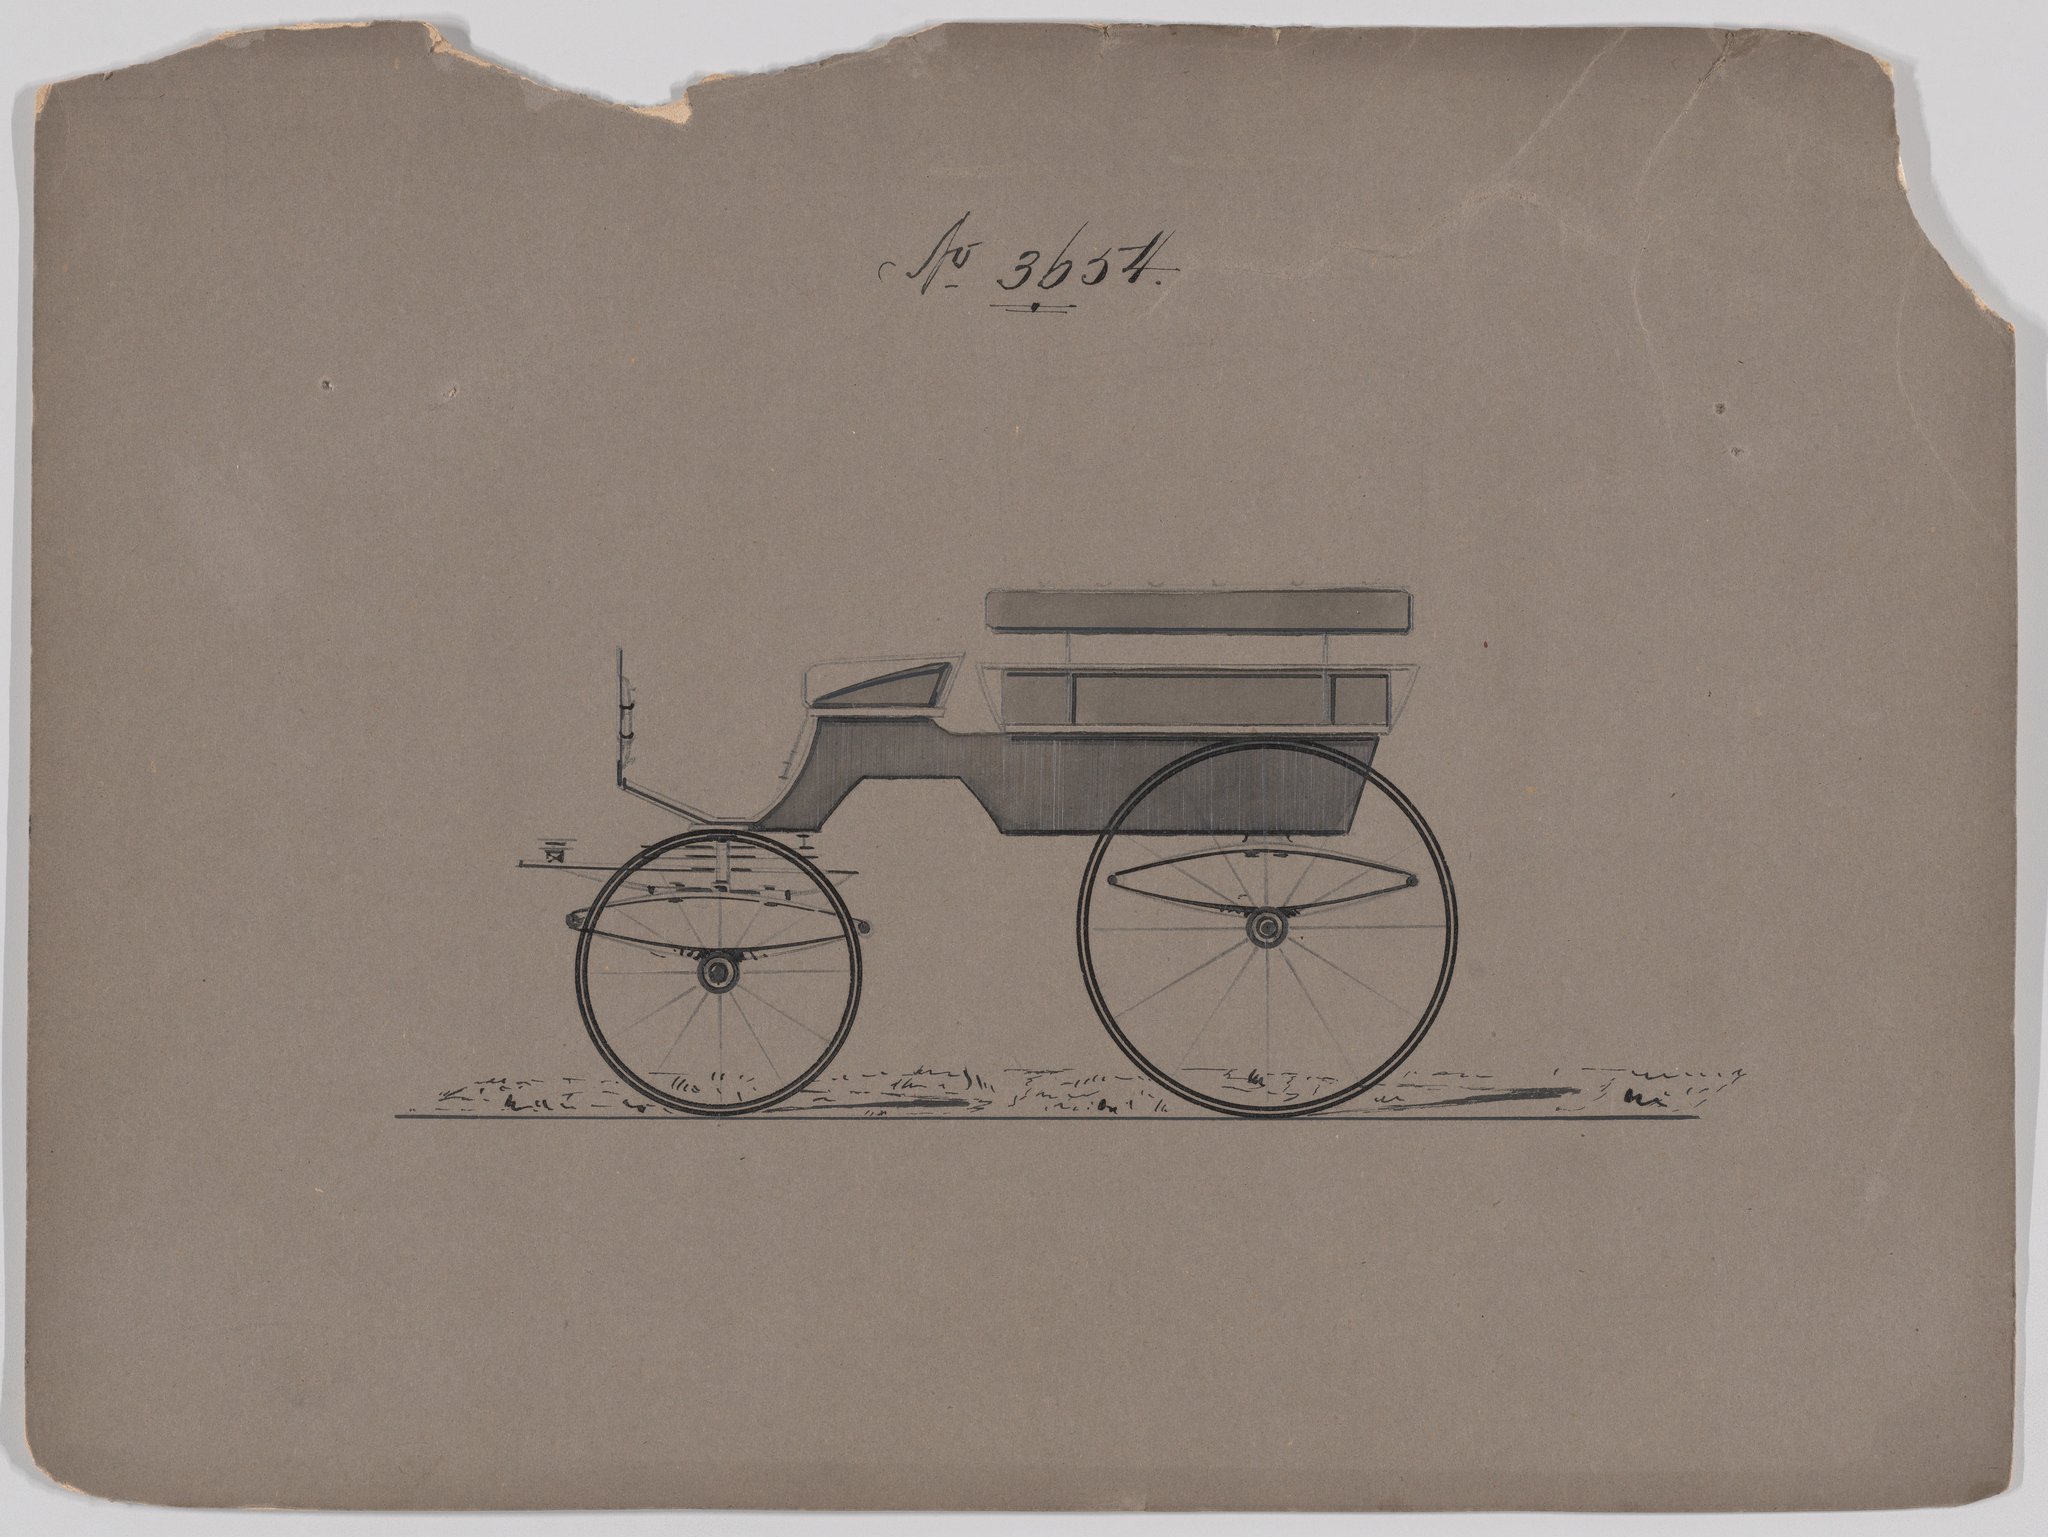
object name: drawing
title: Design for Omnibus or Wagonette, no. 3654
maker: brewster & co.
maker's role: manufacturer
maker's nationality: american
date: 1881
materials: graphite, ink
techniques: pen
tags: carriages